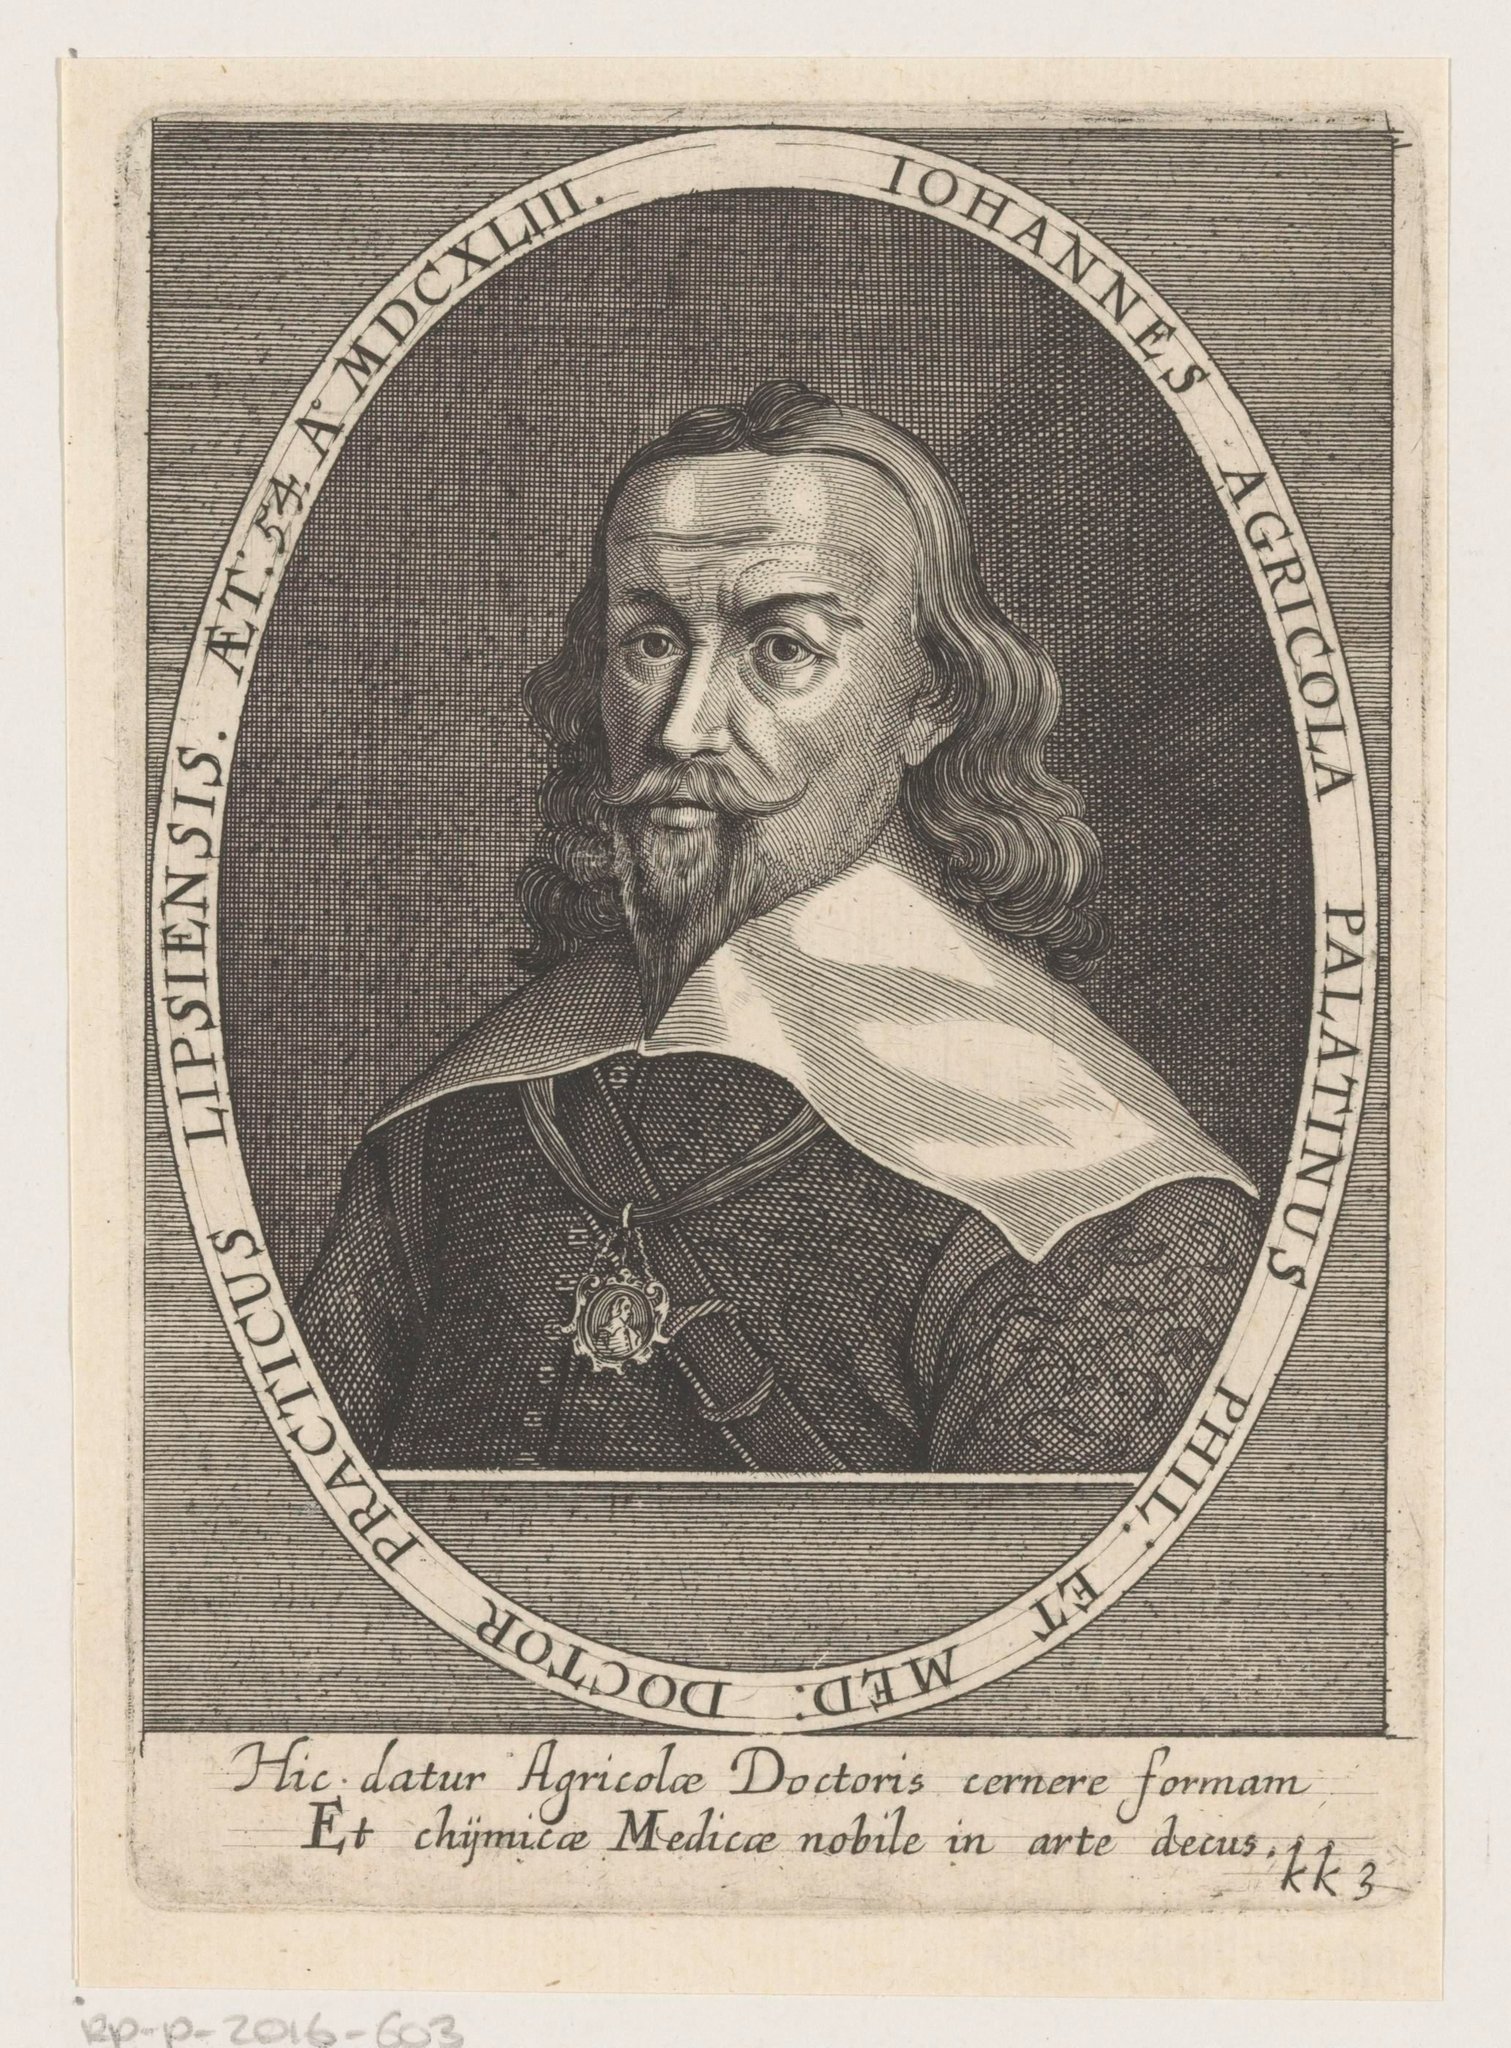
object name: print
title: Portret van Johannes Agricola II op 54-jarige leeftijd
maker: Anonymous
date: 1643-1699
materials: paper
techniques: engraving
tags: beieren, breslau, alchemist, arts, johann agricola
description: Portret van Johannes Agricola II in een ovale omlijsting met randschrift. In de ondermarge twee regels Latijnse tekst. Rechtsonder: kk 3.